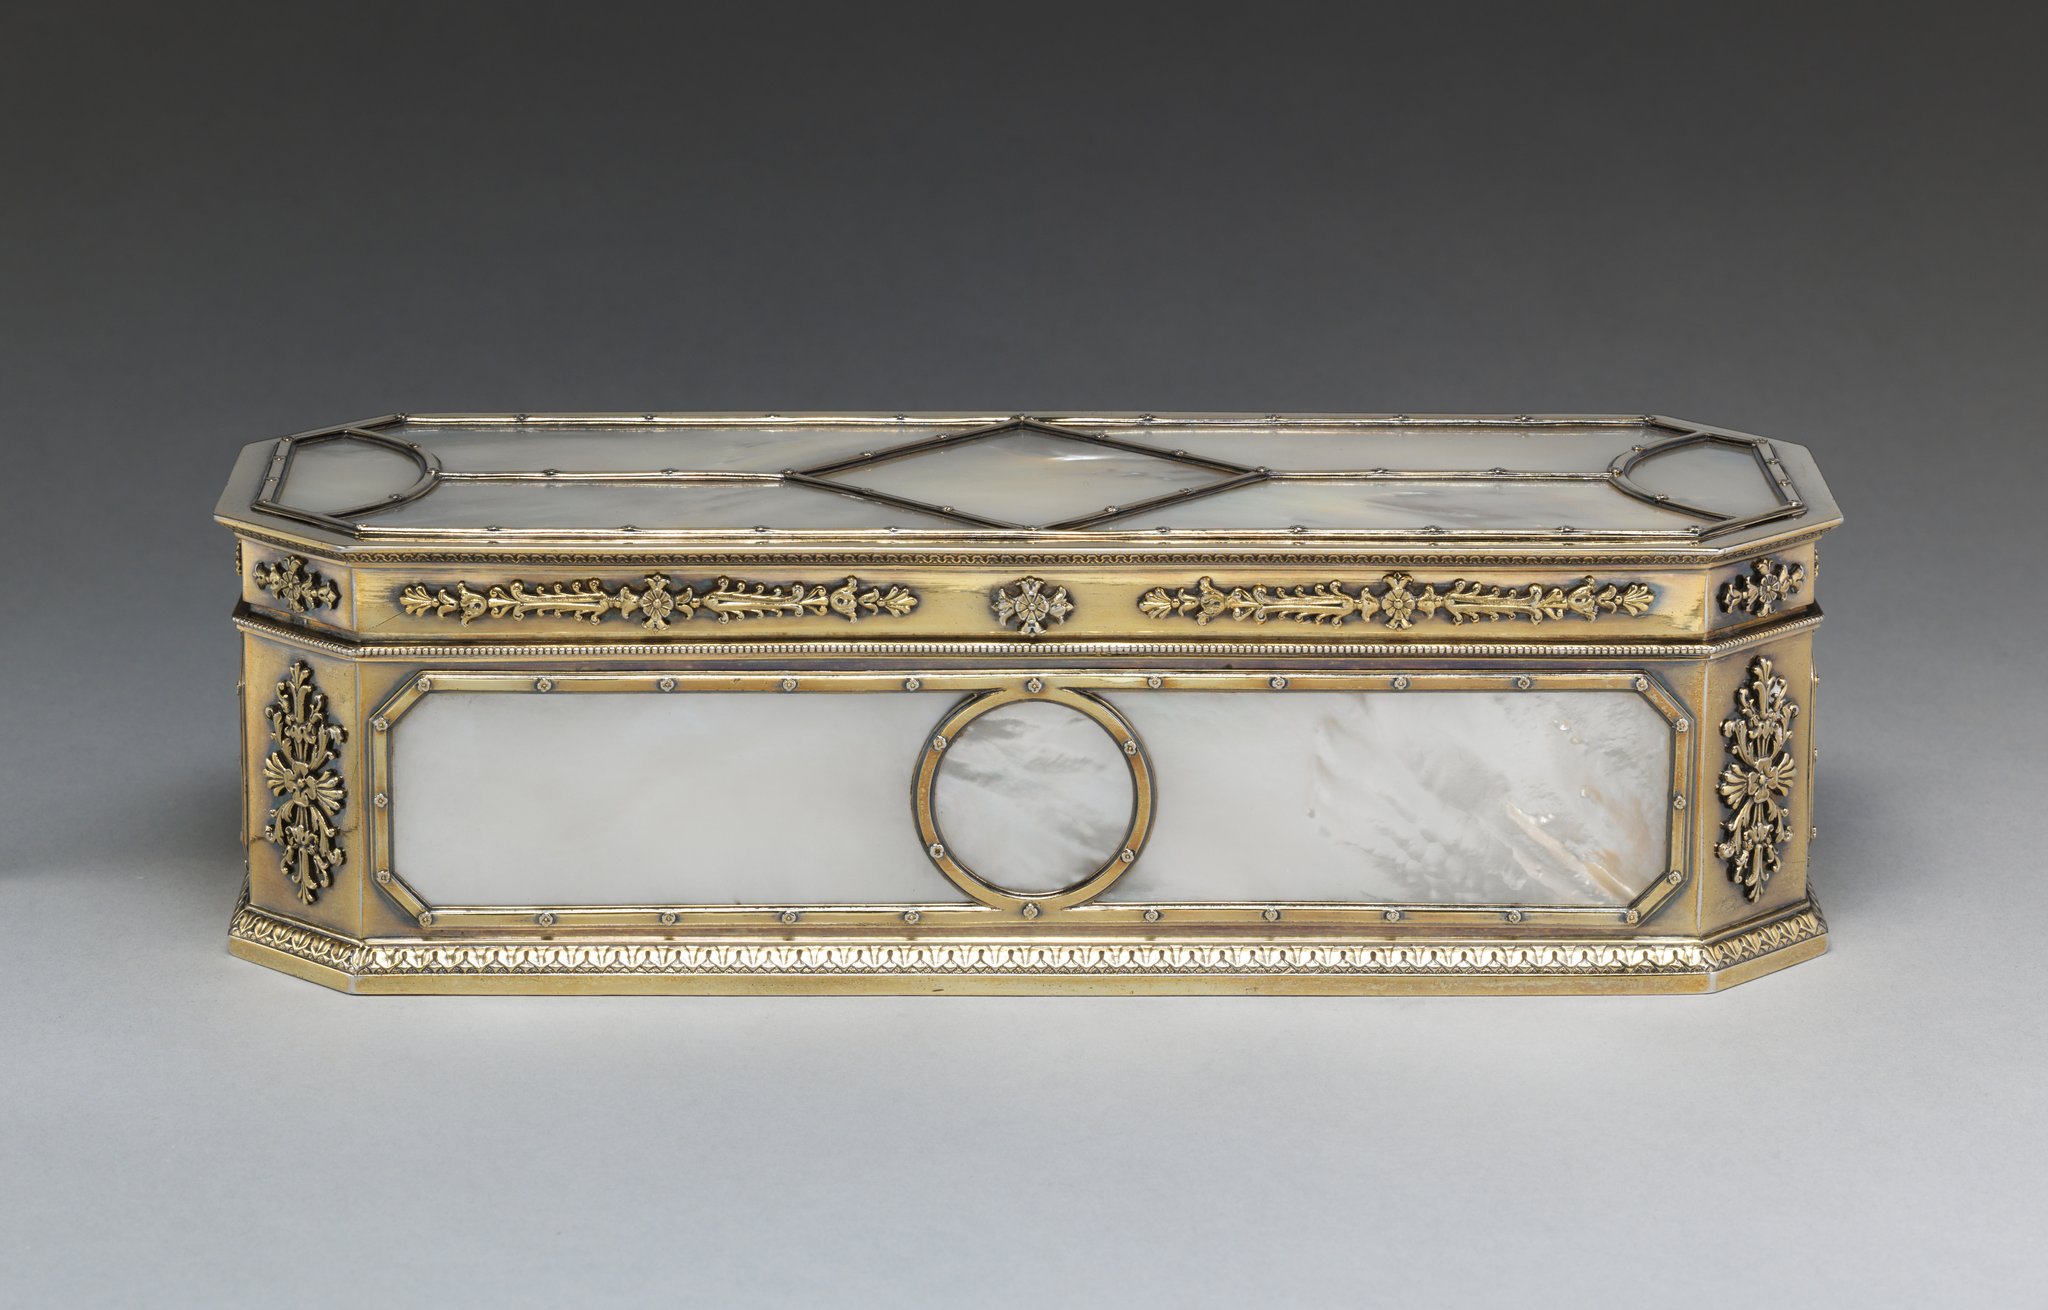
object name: box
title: Rectangular box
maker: andré aucoc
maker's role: maker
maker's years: 1825-1925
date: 1887-1911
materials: mother of pearl, silver gilt